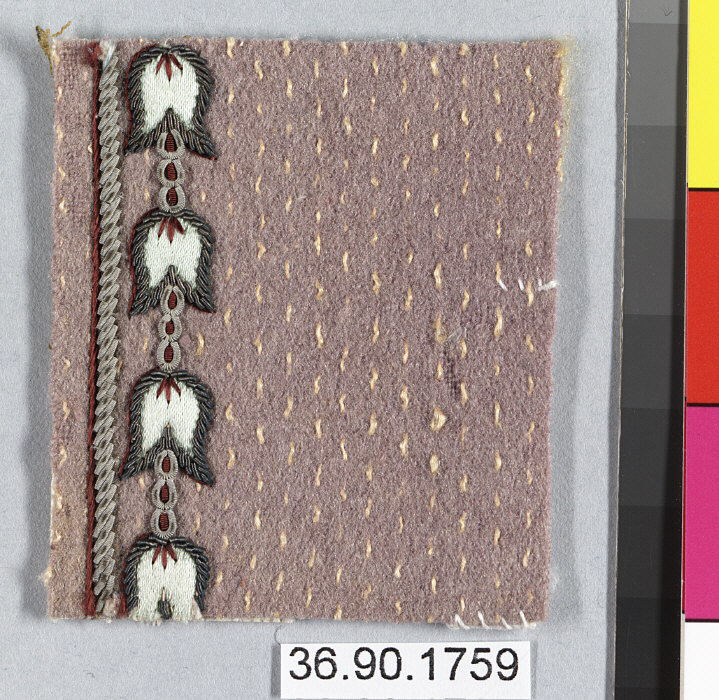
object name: sample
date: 1801-1833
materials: felt, metal thread, silk